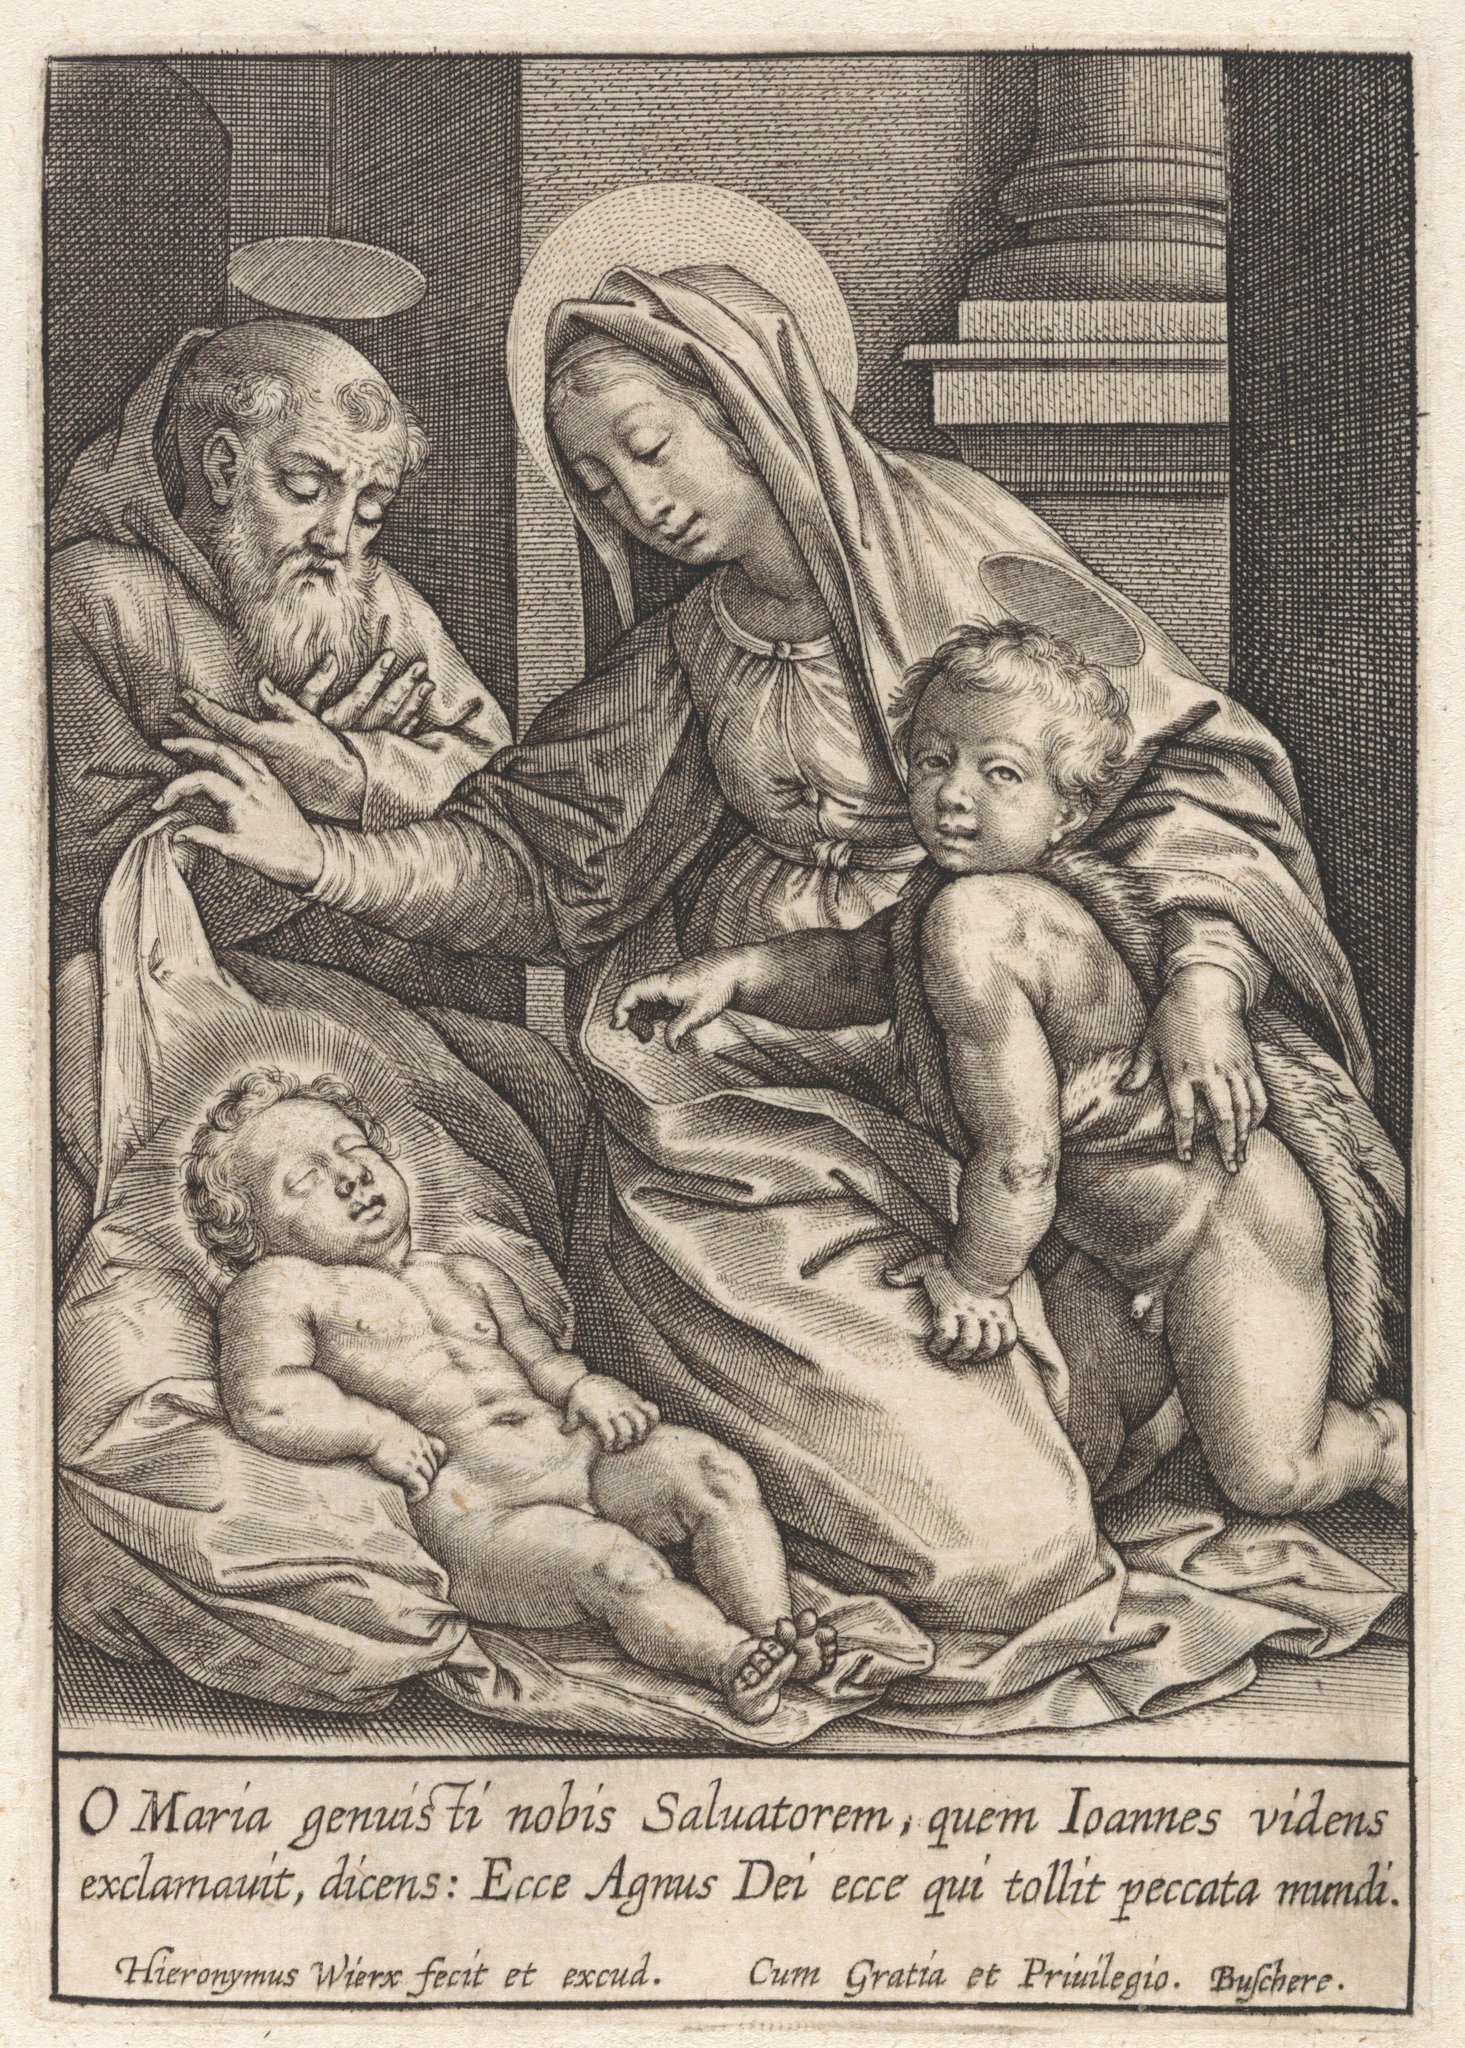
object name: print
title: Heilige Familie bij het slapende Christuskind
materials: paper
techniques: engraving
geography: antwerp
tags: holy family with john the baptist (as child), sleeping; unconsciousness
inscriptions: collector's mark: Lugt 2228, number: ‘48’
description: Maria tilt het laken op van het slapende Christuskind. Ze heeft haar arm om de jonge Johannes de Doper heen geslagen. Jozef zit achter het Kind, de armen gevouwen voor zijn borst. In de marge een tweeregelig onderschrift in het Latijn.